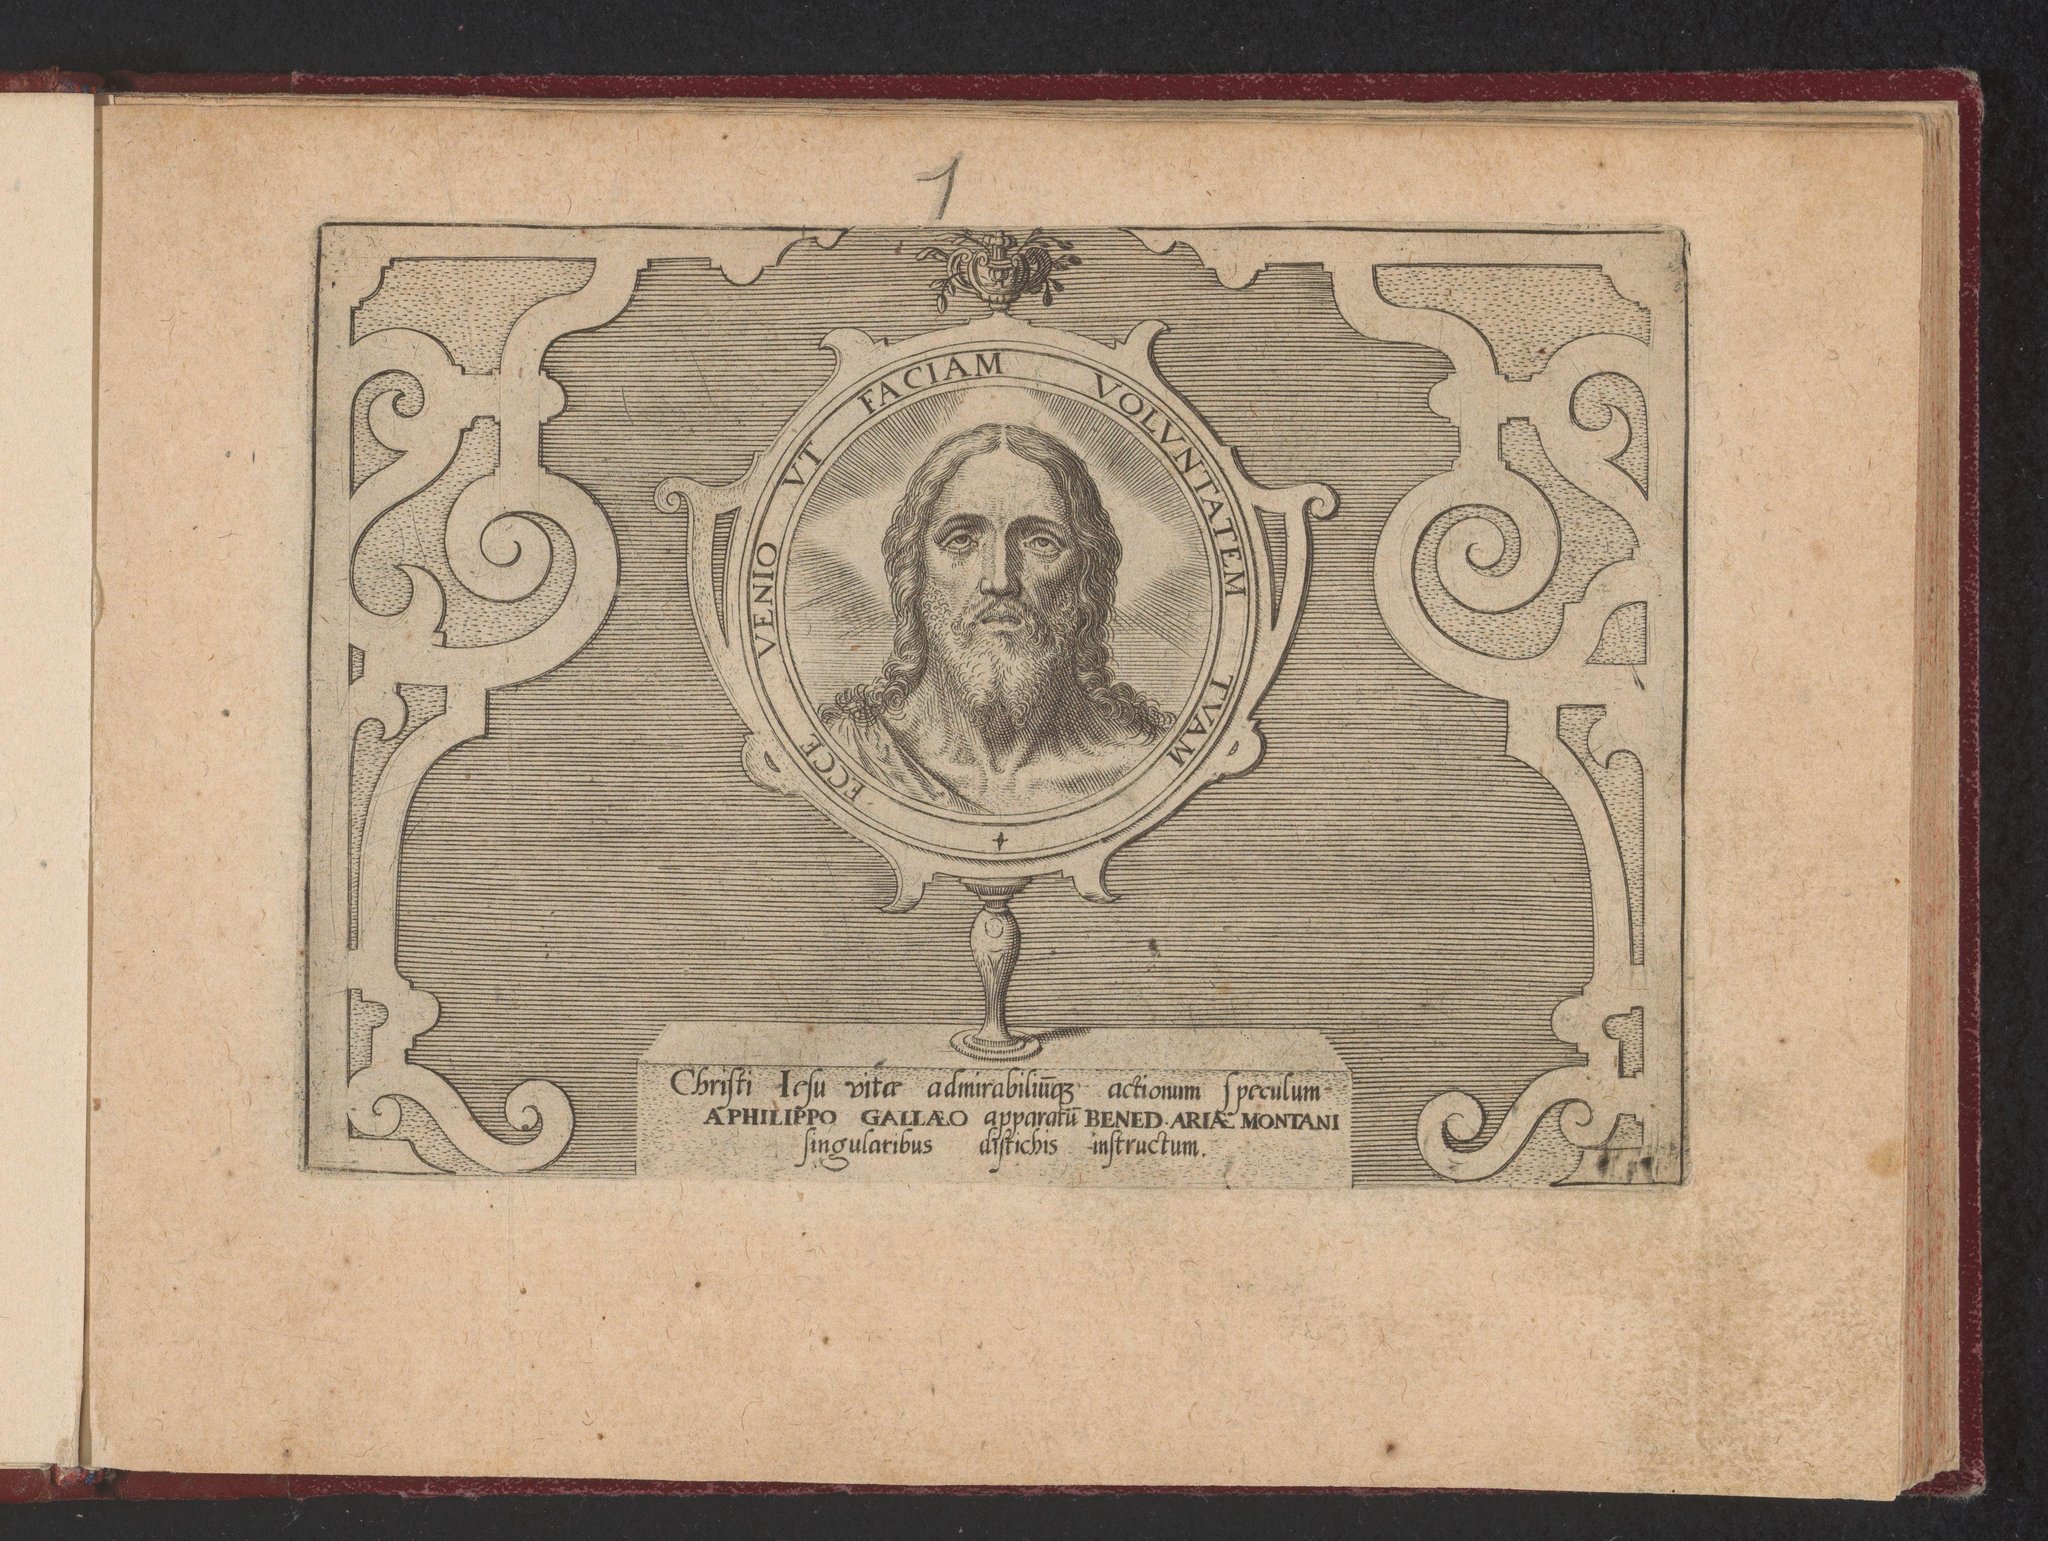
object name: titelprent, frontispice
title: Christi Iesu vitae admirabiliumque actionum speculum a Philippo Gallaeo apparatum Bened. Ariae Montani singuloribus distichis instructum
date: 1573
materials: paper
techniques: engraving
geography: antwerp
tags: mirror, 'portraits' of christ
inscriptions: watermark: ‘gotische letter P’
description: Onderdeel van een album met een titelprent en een serie van 50 prenten betreffende het leven en de passie van Christus.